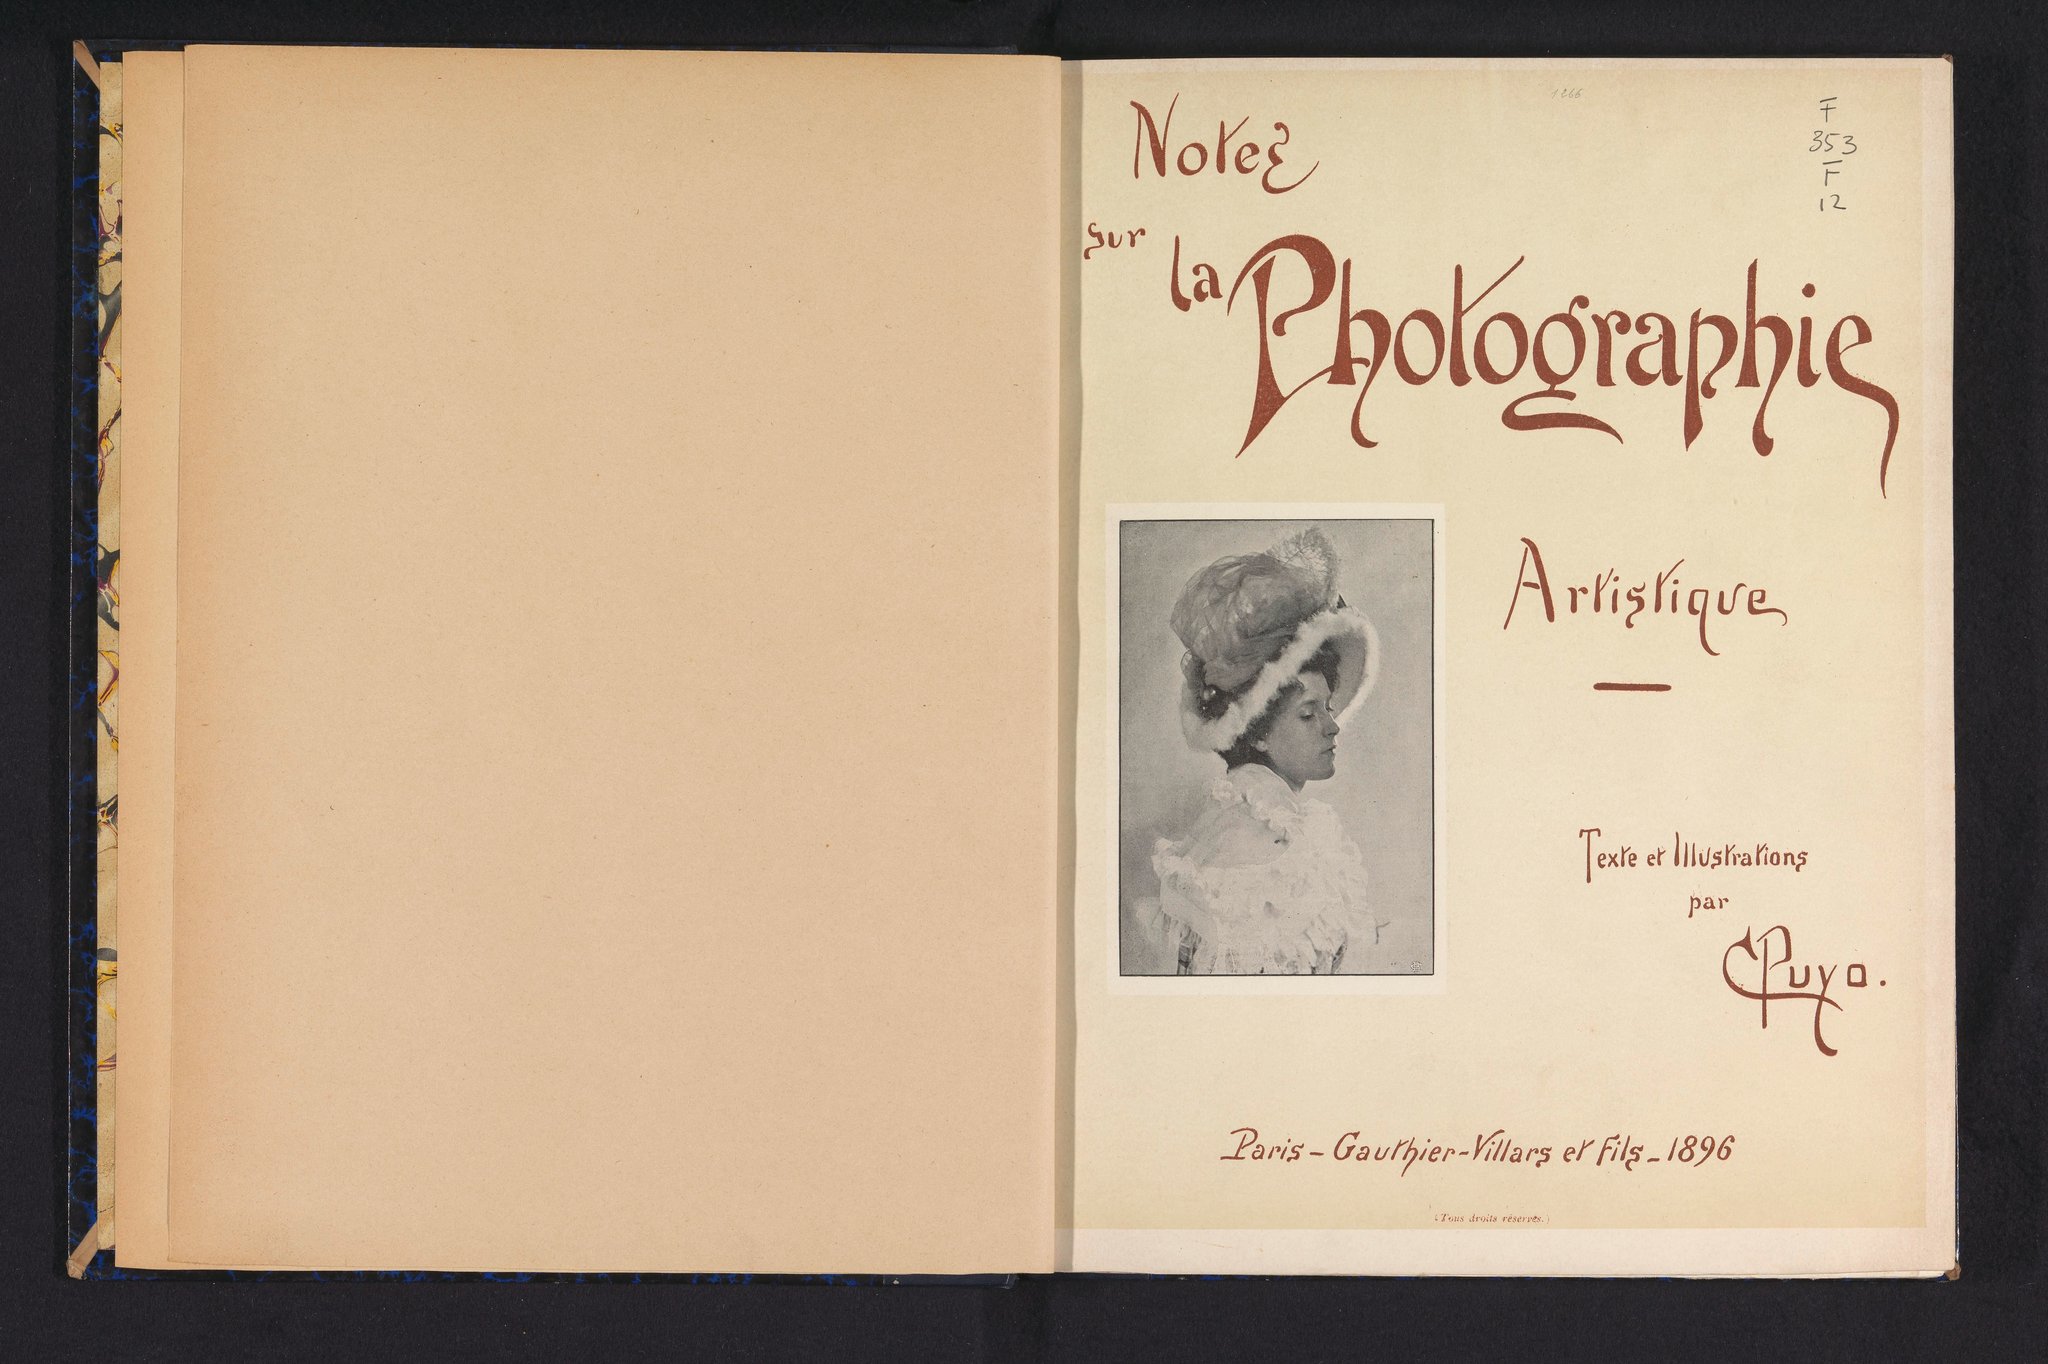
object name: photomechanical print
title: Portret van een onbekende vrouw met een hoed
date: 1886-1896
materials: paper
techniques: autotype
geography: france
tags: adult woman, head-gear: hat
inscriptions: inscription: ‘CB’